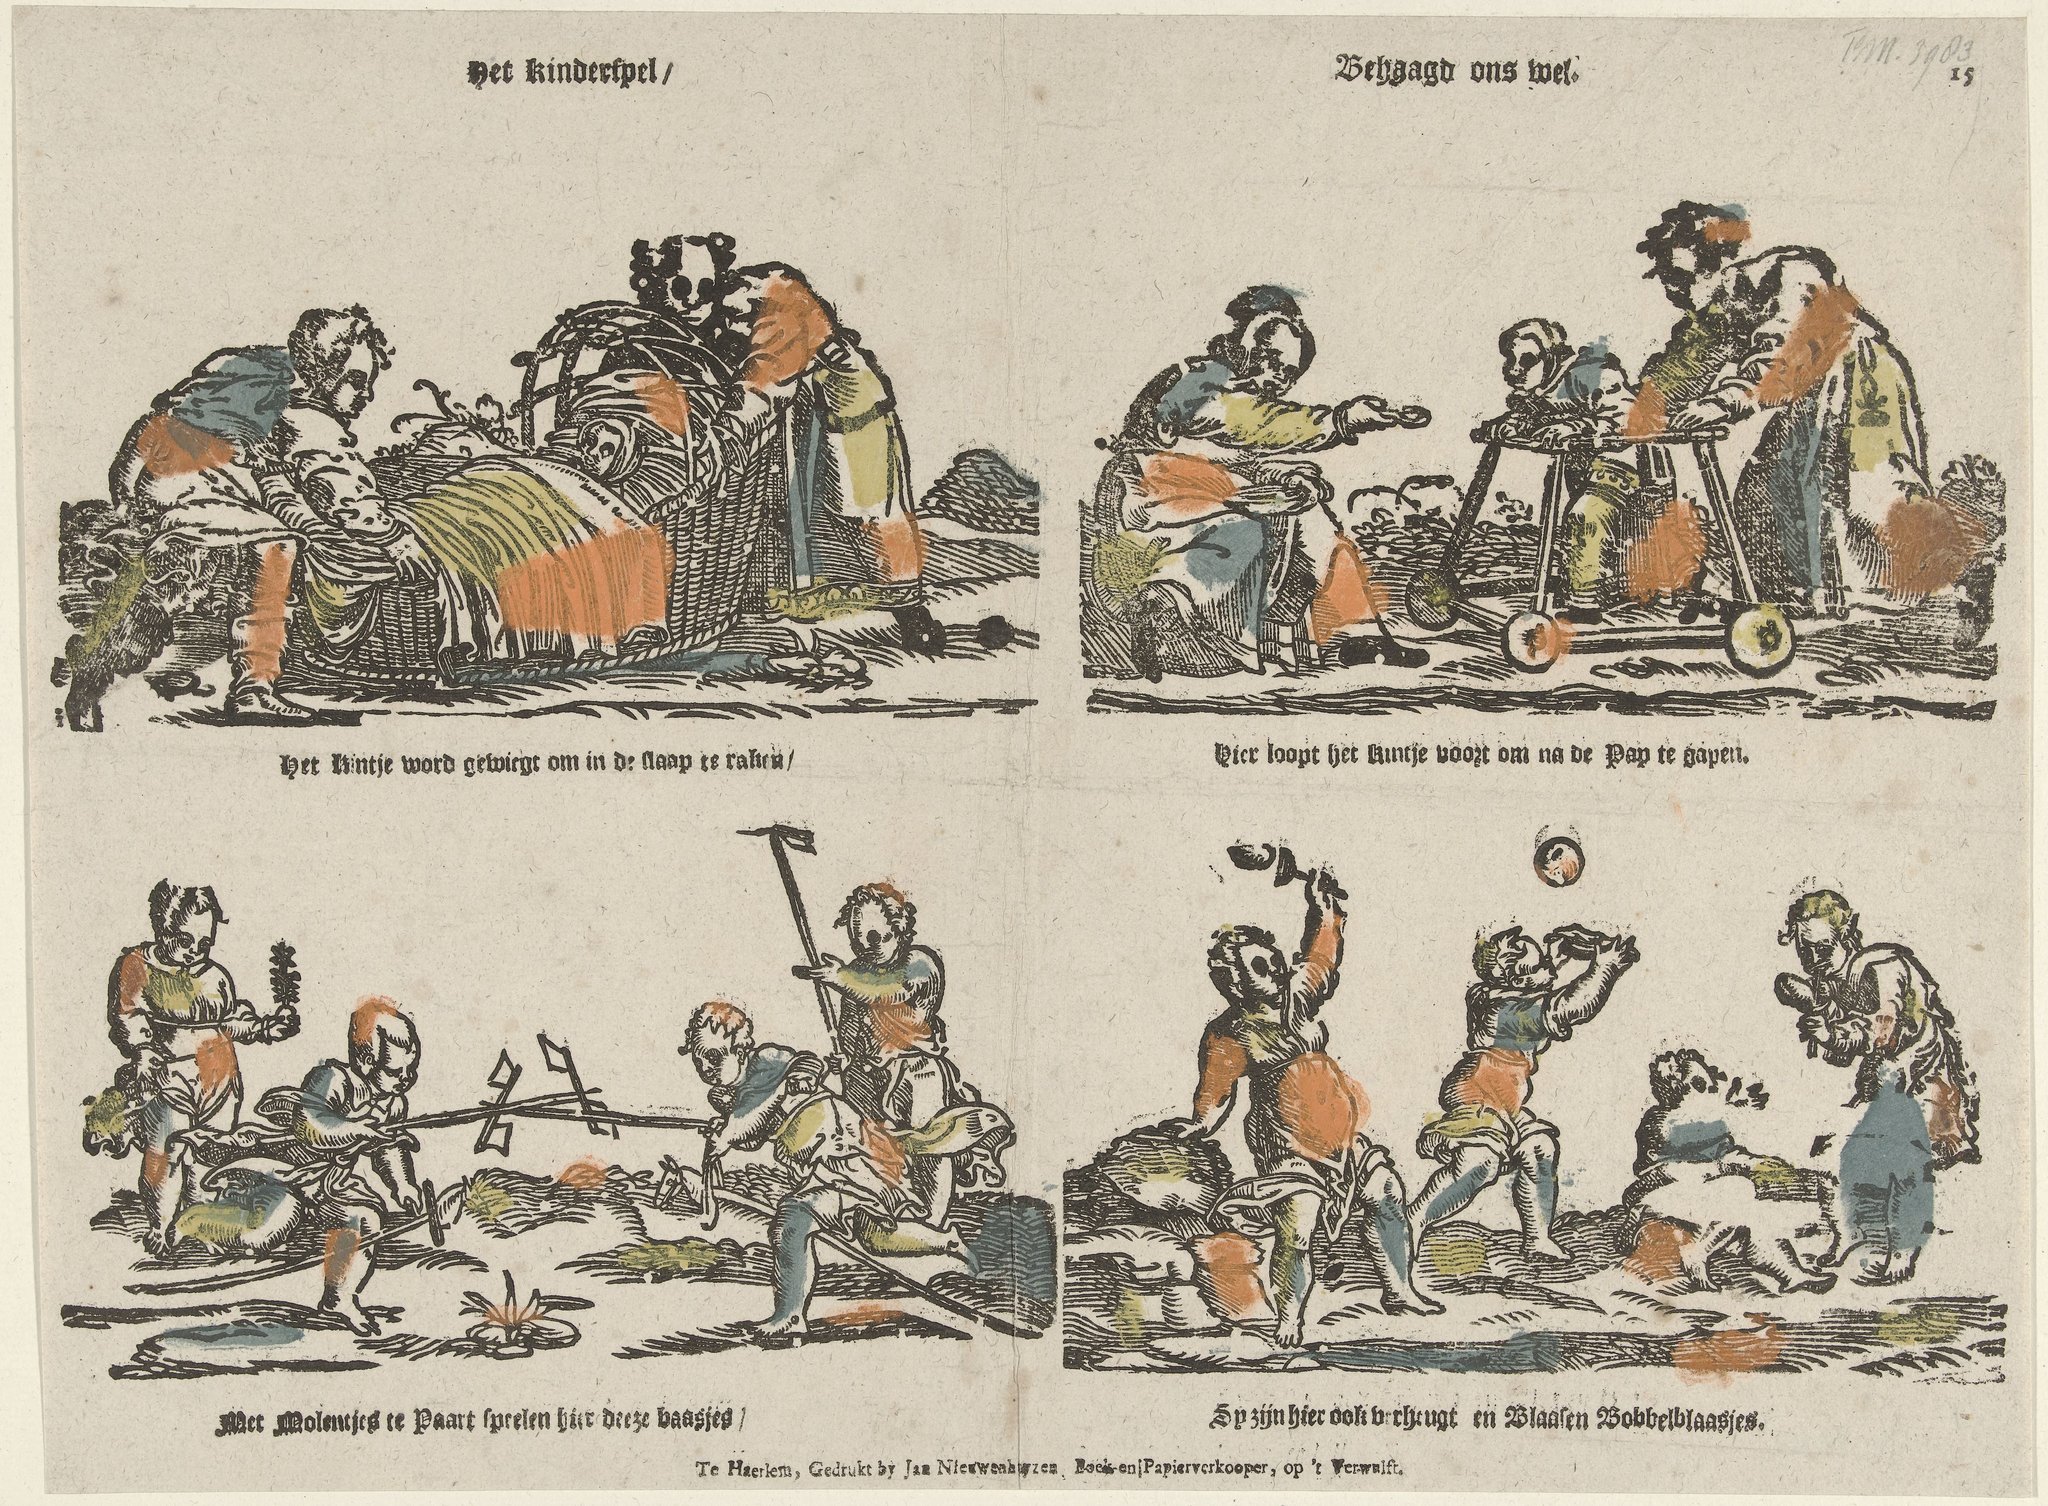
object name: popular print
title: Het kinderspel / Behaagt ons wel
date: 1743-1758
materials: paper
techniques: colour, letterpress printing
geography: netherlands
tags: children's games and plays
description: Blad met 4 voorstellingen van kinderspelen: wiegen, rolwagen, stokpaardjes met molentjes en bellenblazen. Onder elk plaatje een regel van een vers. Genummerd rechtsboven: 15.